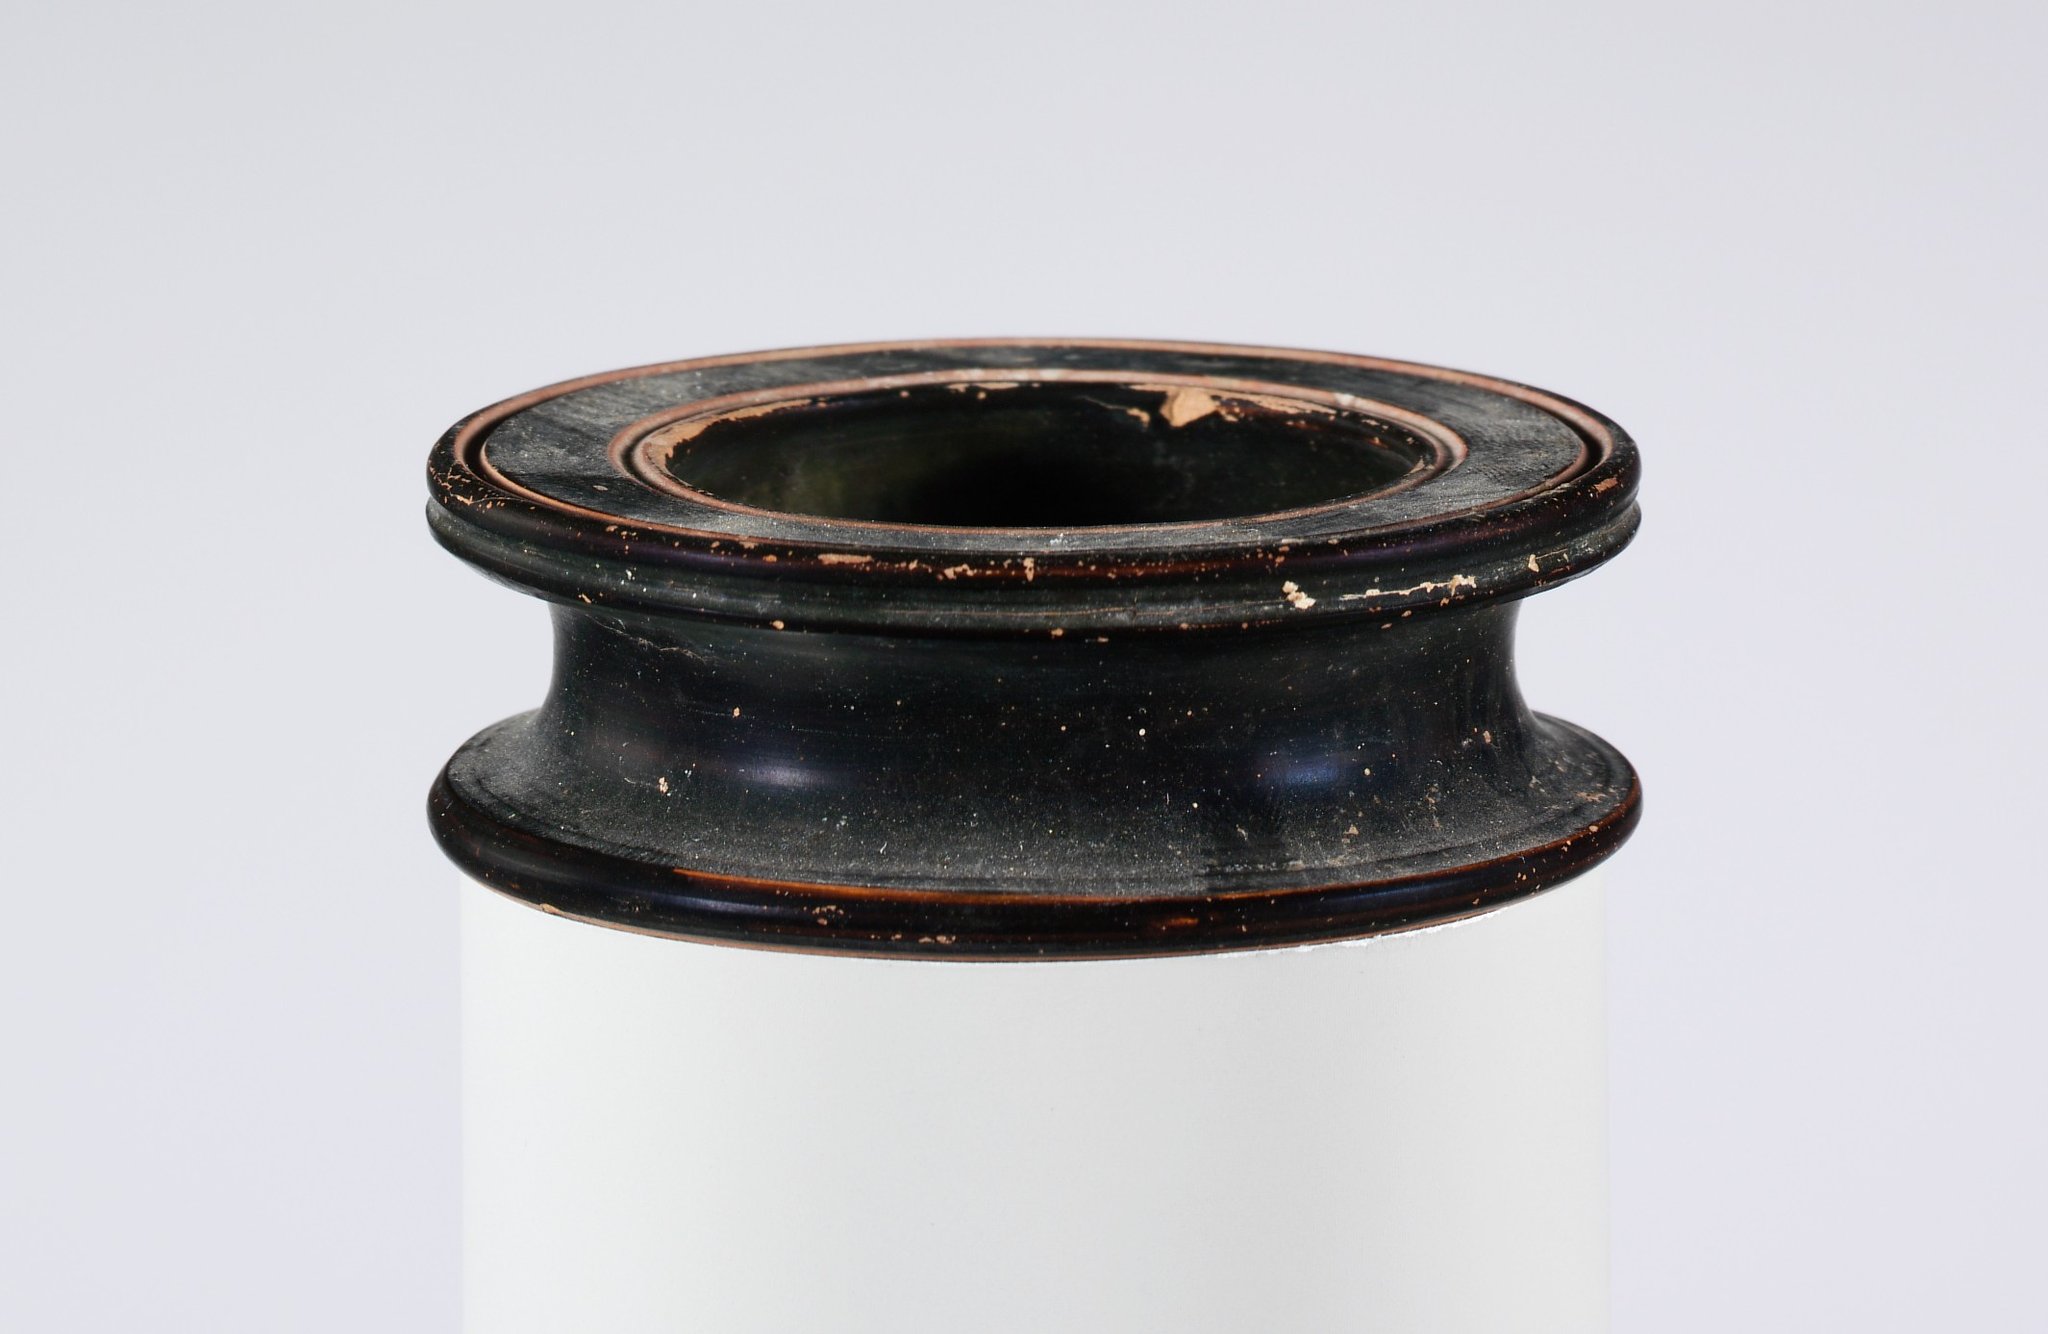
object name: stand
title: Terracotta stand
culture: greek, attic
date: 534-401 BCE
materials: terracotta